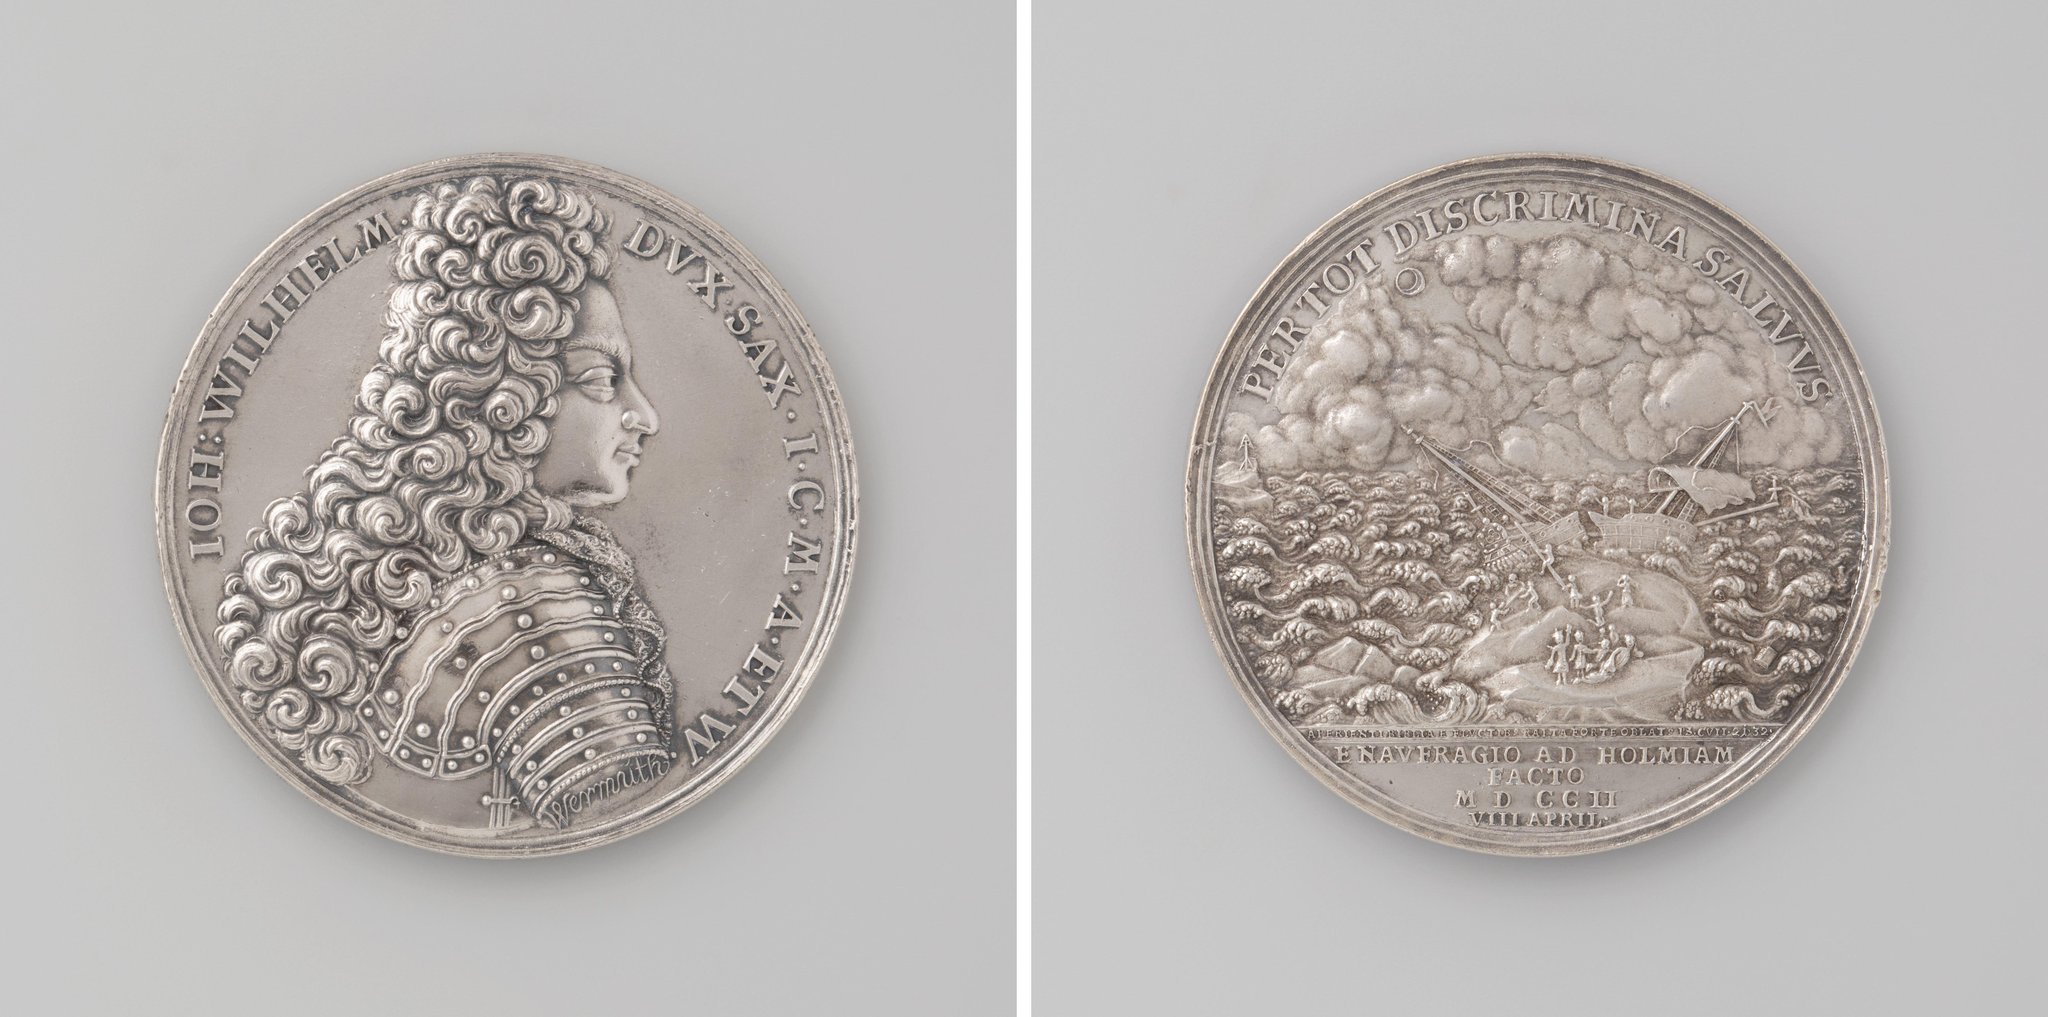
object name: history medal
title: Johann Willem van Saksen-Gotha, wegens het overleven van zijn schipbreuk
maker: christian wermuth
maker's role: medailleur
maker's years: 1661-1739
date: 1702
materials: silver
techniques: striking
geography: gotha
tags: toulon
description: Zilveren penning. Voorzijde: borststuk man binnen omschrift. Keerzijde: schip dat strandt tijdens zwaar weer binnen omschrift, boven opschrift